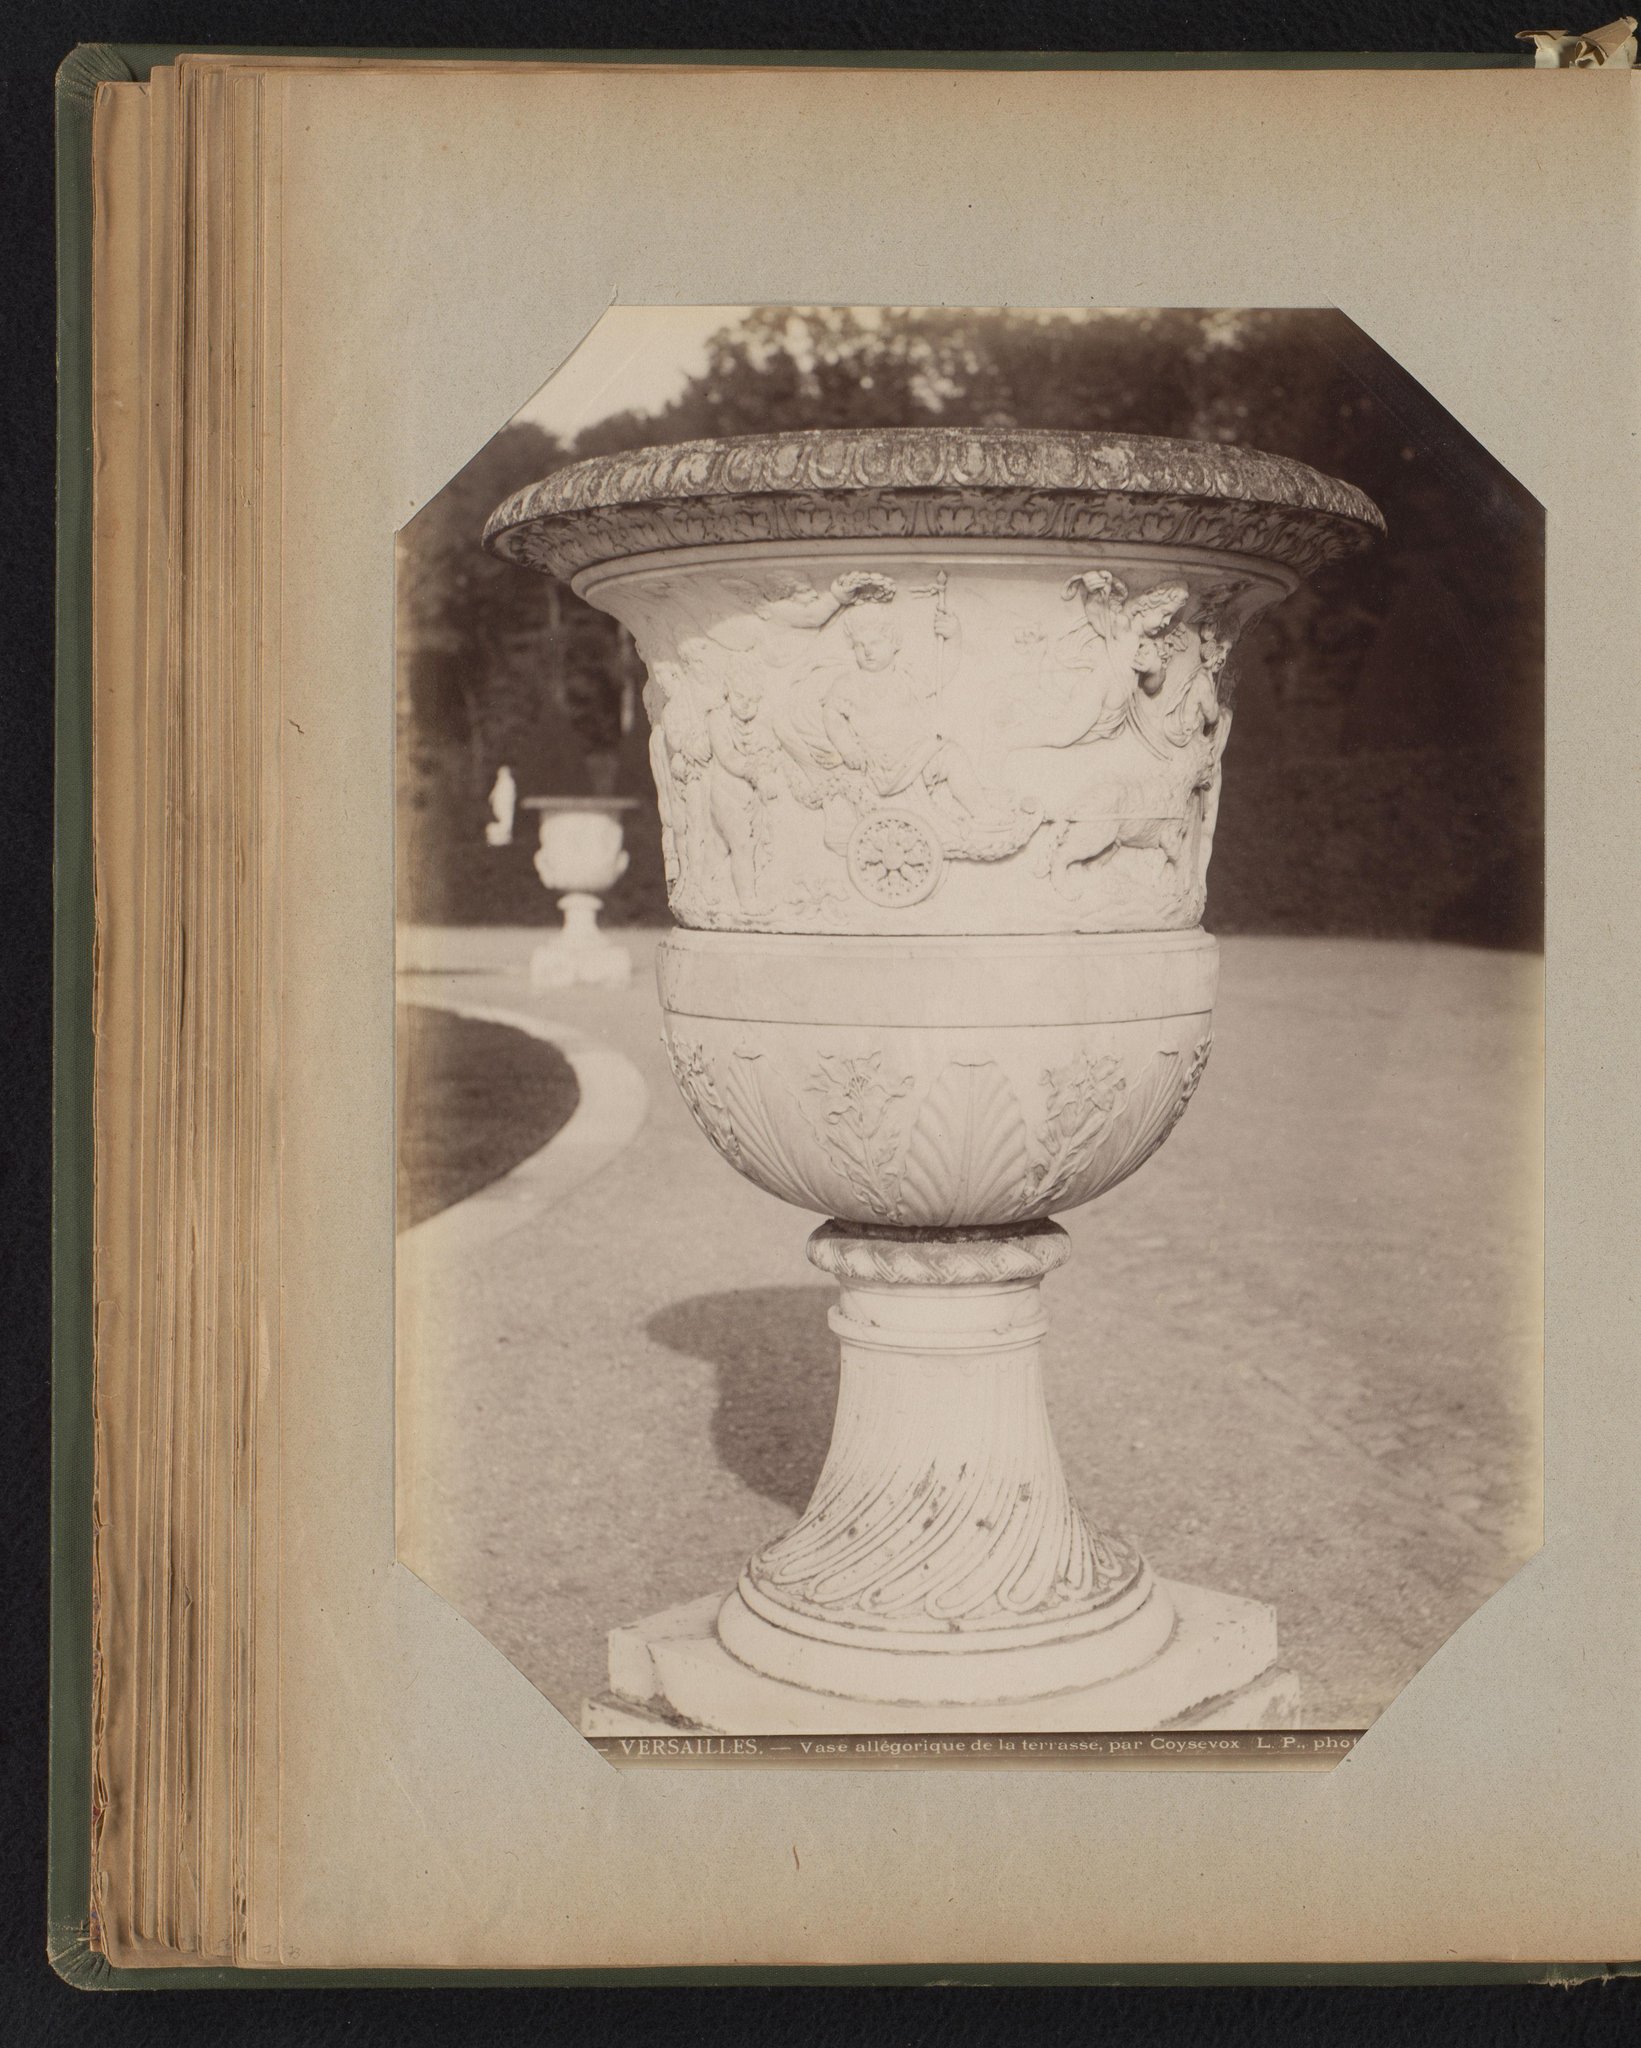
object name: photograph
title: 271 - Versailles - Vase allegorique de la terrasse par Coysevox. (L.P. Phot).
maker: Anonymous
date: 1860-1900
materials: paper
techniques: albumen print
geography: france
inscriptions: annotation: ‘271 - Versailles - Vase allegorique de la terrasse par Coysevox. (L.P. Phot).’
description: Onderdeel van een serie met betrekking tot het interieur van het paleis van Versailles met kroonluchters, deuren, portalen en meubelstukken.